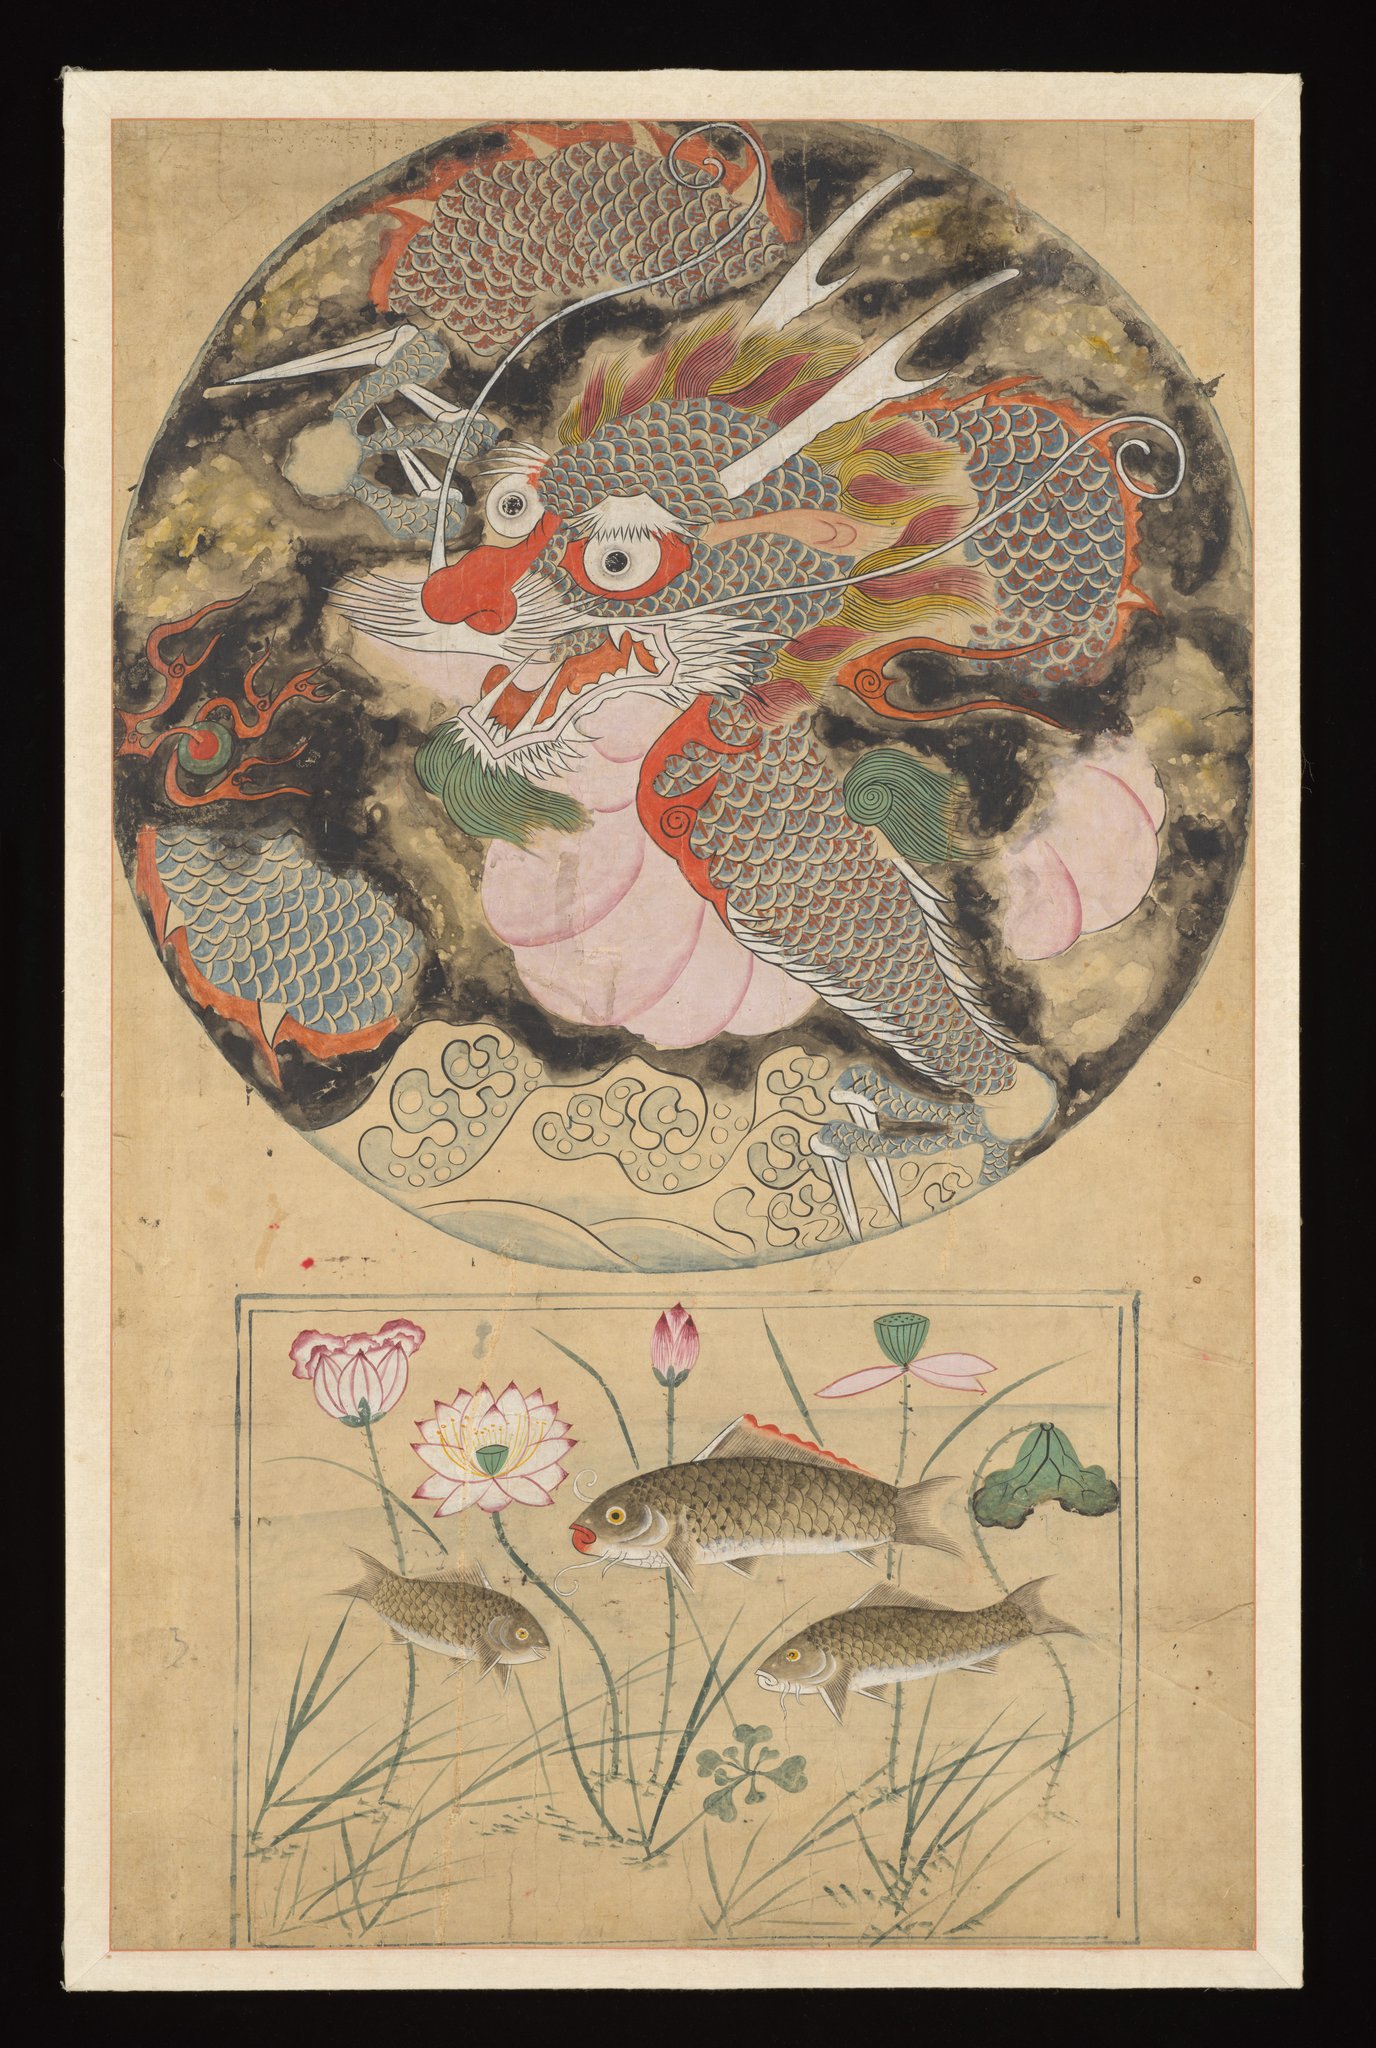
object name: painting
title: Dragon and carp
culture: korean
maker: unidentified artist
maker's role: artist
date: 1867-1900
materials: ink, paper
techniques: painting